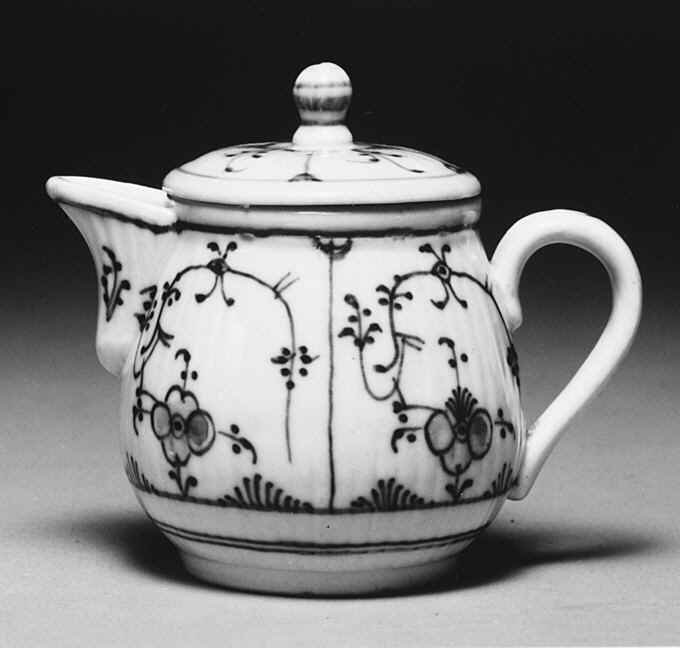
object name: milk jug with cover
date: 1801-1900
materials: hard paste porcelain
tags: flowers